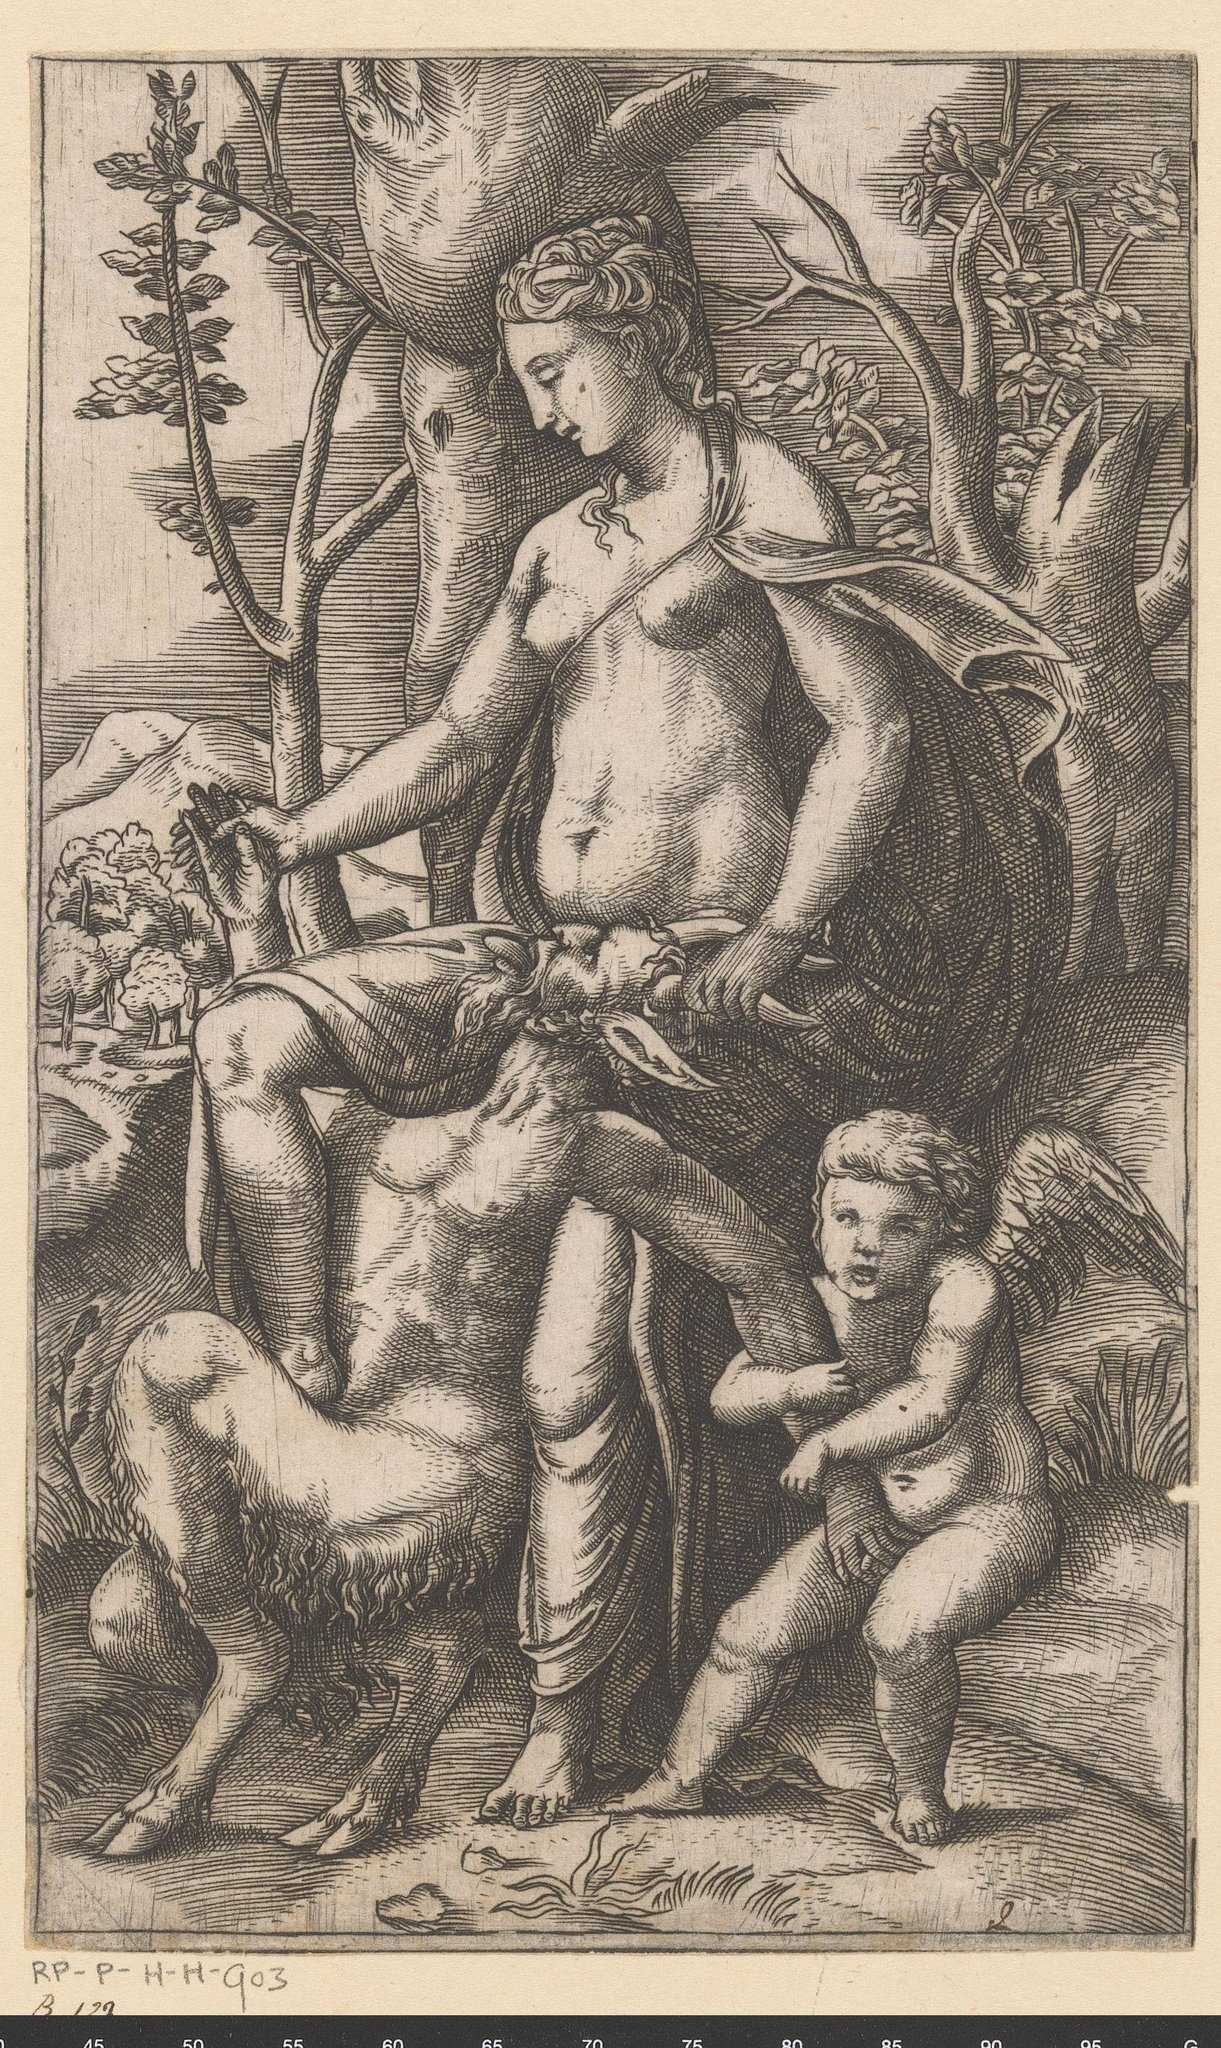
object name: print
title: Venus bedwingt een sater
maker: Anonymous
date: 1500-1599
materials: paper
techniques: engraving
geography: italy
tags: landscapes, satyr(s) (in general), venus and cupid (cupid not being mere attribute)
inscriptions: number: ‘4’, collector's mark: ‘Hinloopen’, number: ‘2’, collector's mark: Lugt 10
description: De staande Venus heeft een sater vastgegrepen bij zijn hand en hoorn, en staat met haar voet op zijn schoot. Rechts Amor die de arm van de sater vasthoudt.